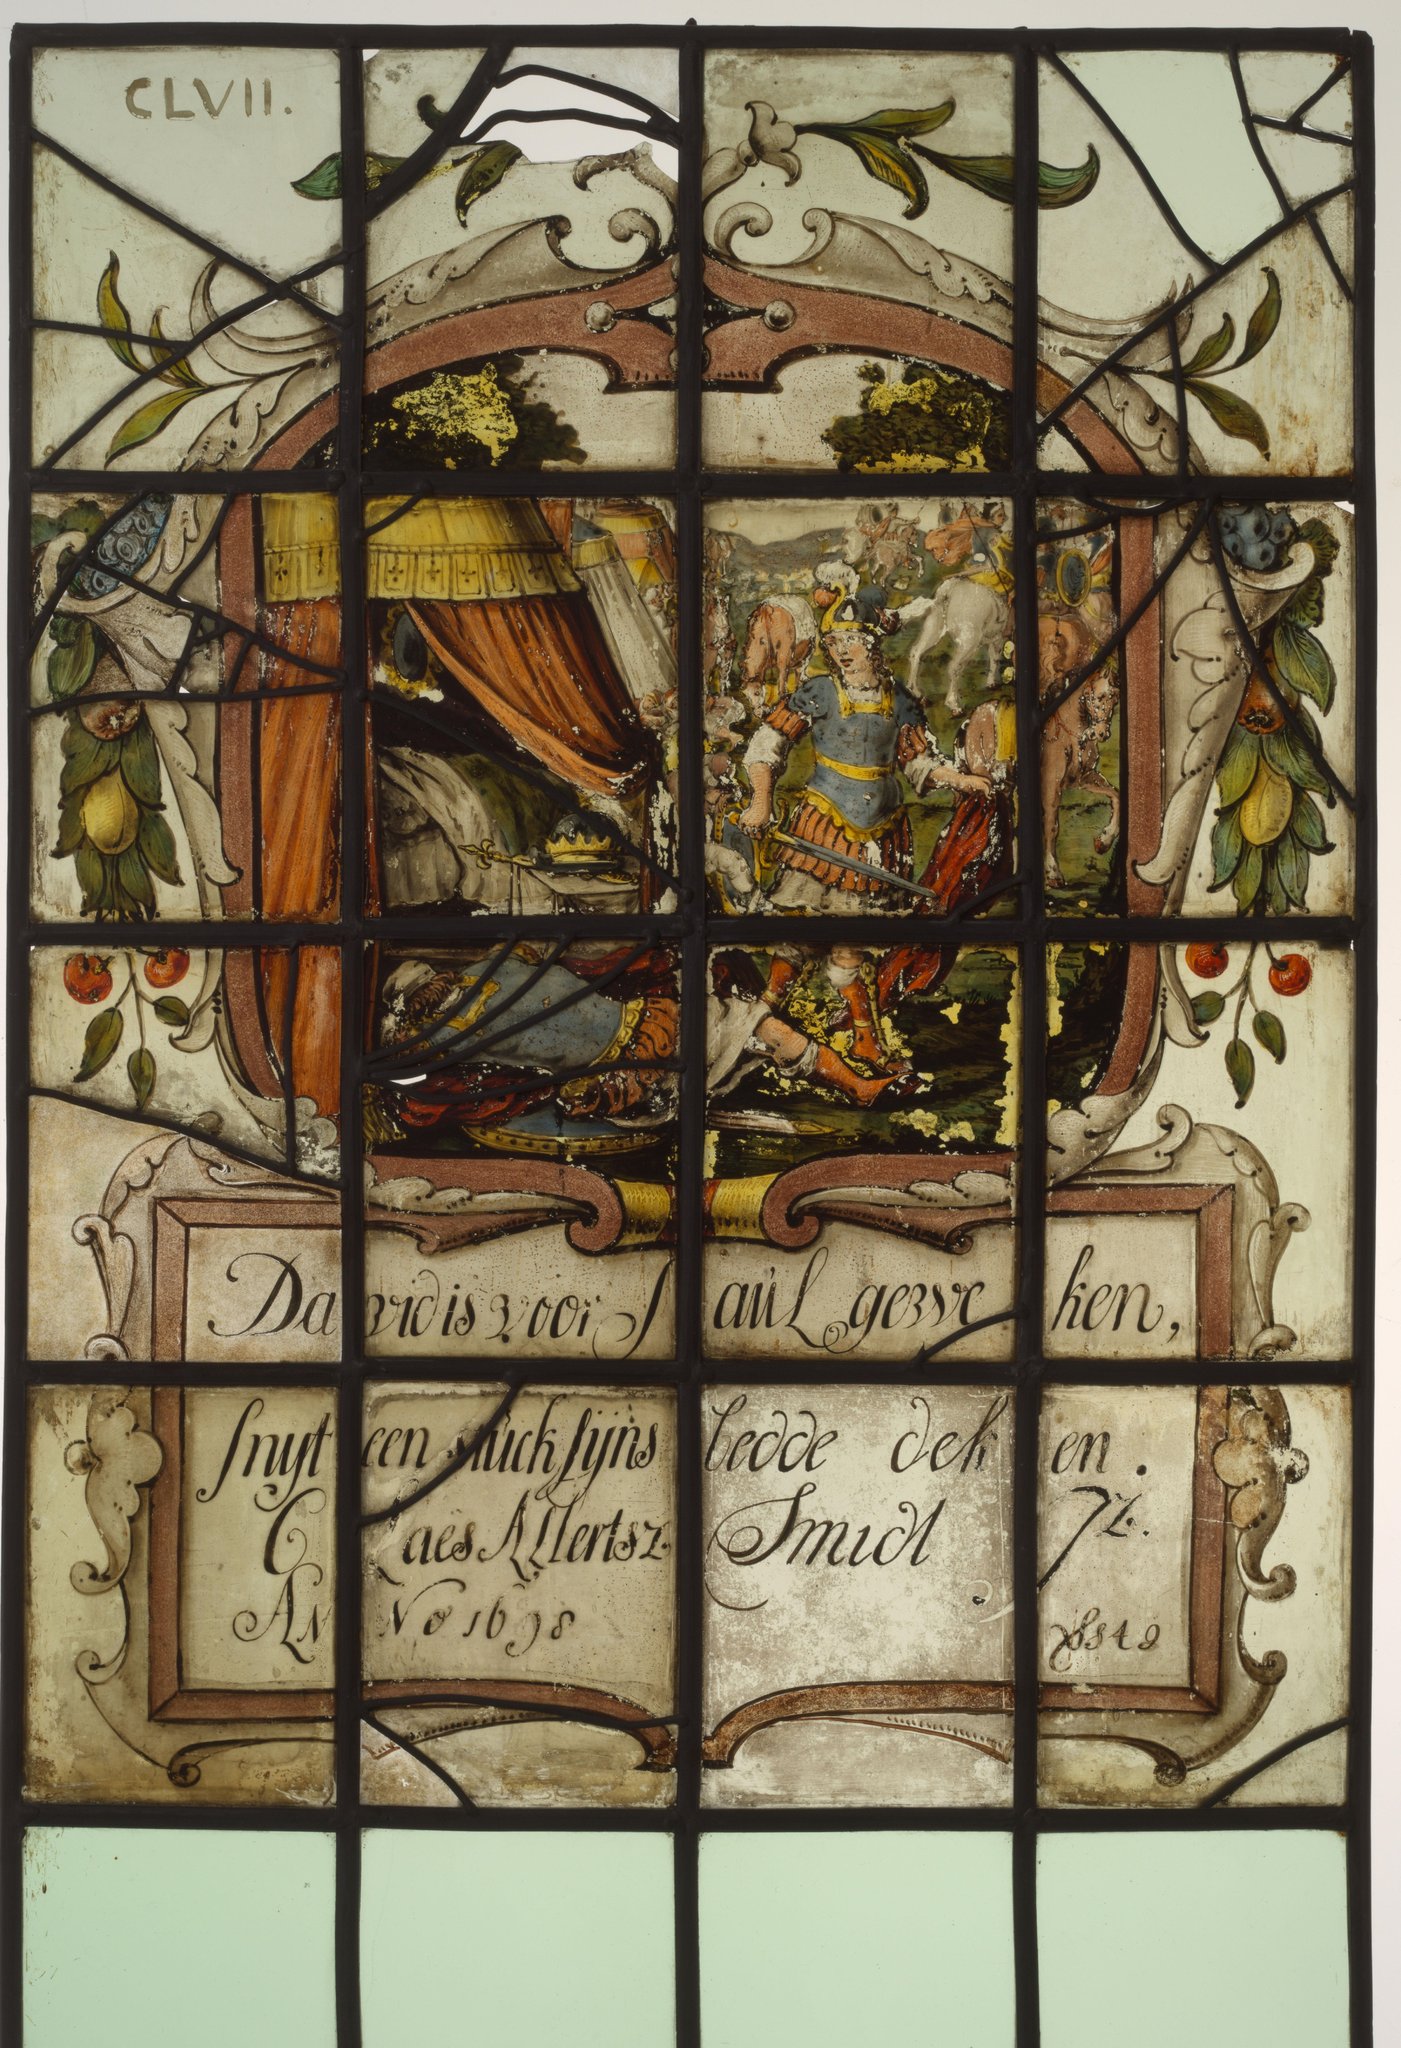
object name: light window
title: Ruit met David die de deken van Saul doorsnijdt waaronder cartouche met opschrift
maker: Anonymous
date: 1698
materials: glass, lead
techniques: leading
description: Paneel met bijbelse voorstelling. David de deken van Saul doorsnijdende. Daaronder een cartouche met opschrift "... Anno 1698".